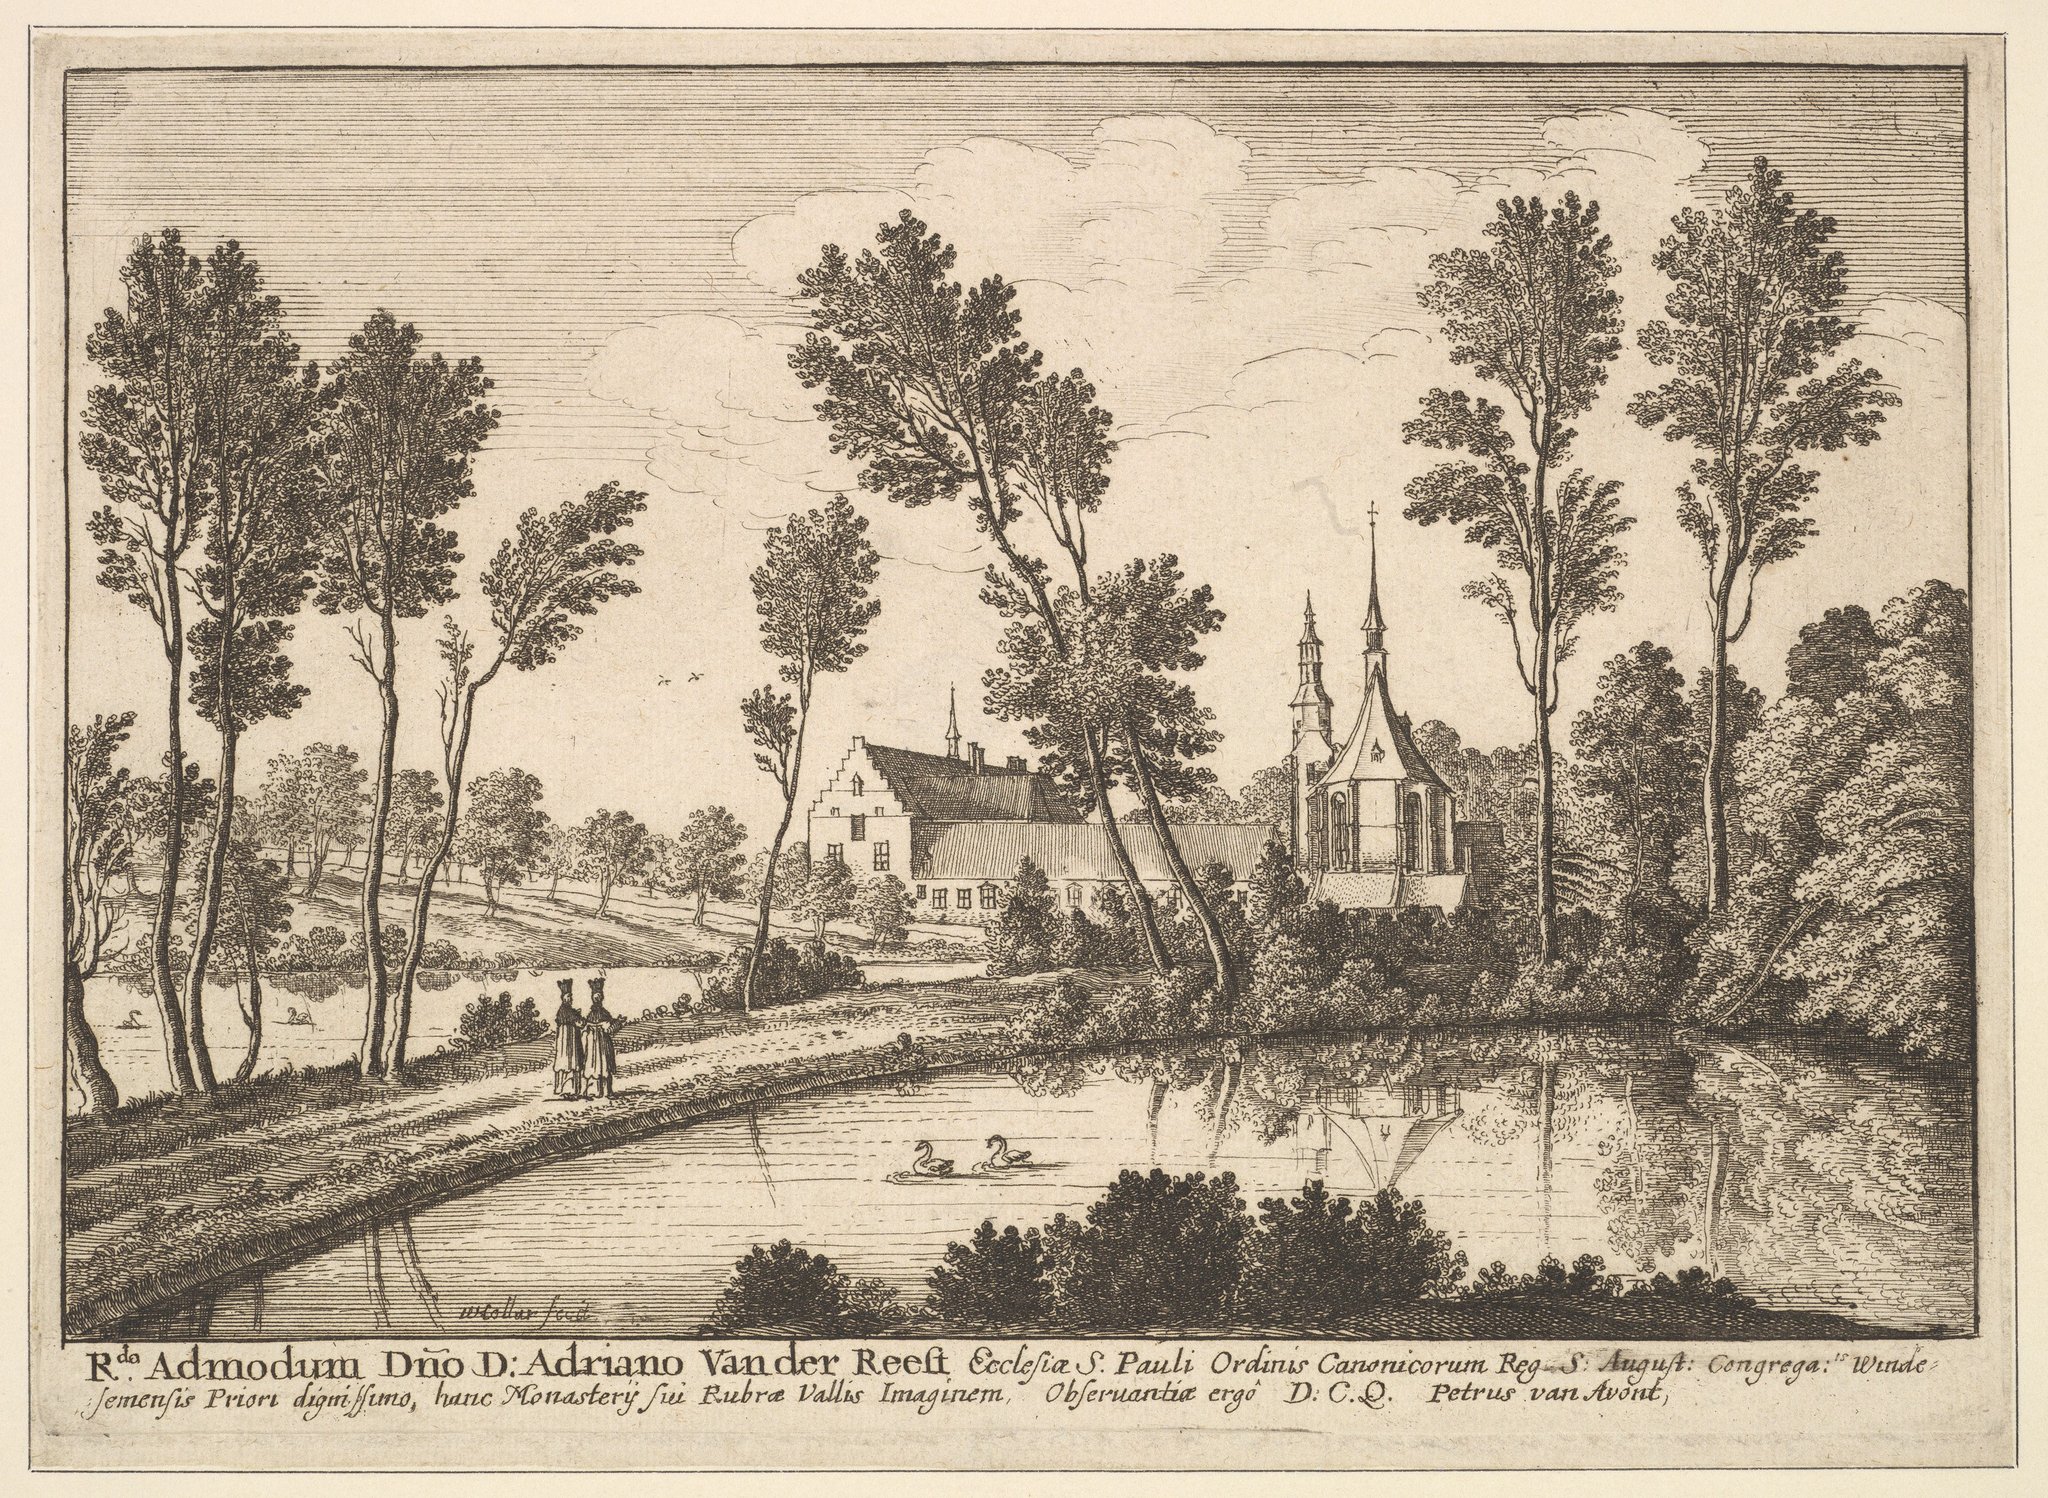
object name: print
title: Rothendael Abbey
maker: wenceslaus hollar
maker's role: artist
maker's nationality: bohemian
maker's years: 1607-1677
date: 1648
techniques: etching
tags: ducks,churches,ponds